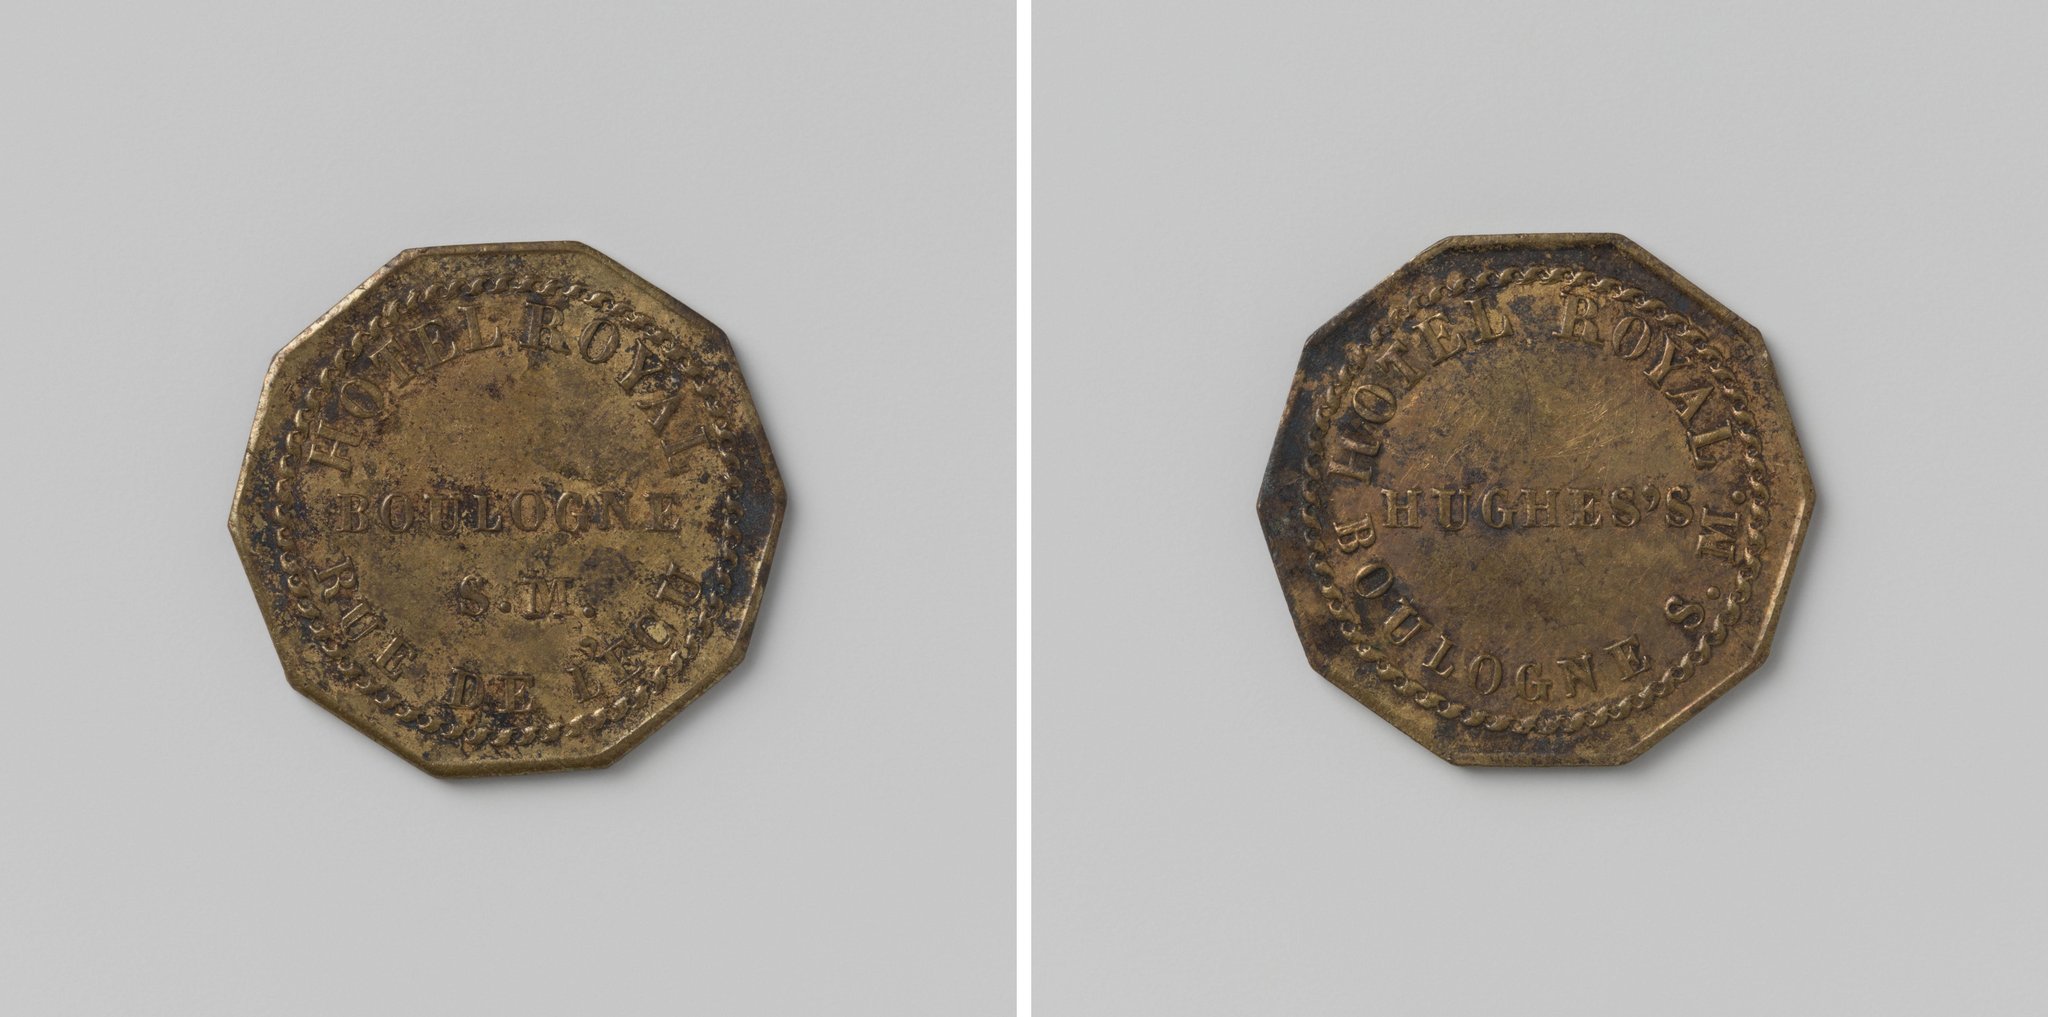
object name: adrespenning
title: Hotel Royal Hughes's, rue de l'ecu te Boulogne-sur-Mer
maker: Anonymous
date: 1850-1880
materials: brass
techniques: striking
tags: boulogne-sur-mer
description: Messing tienhoekige penning. Voorzijde: opschrift binnen omschrift. Keerzijde: opschrift binnen omschrift.